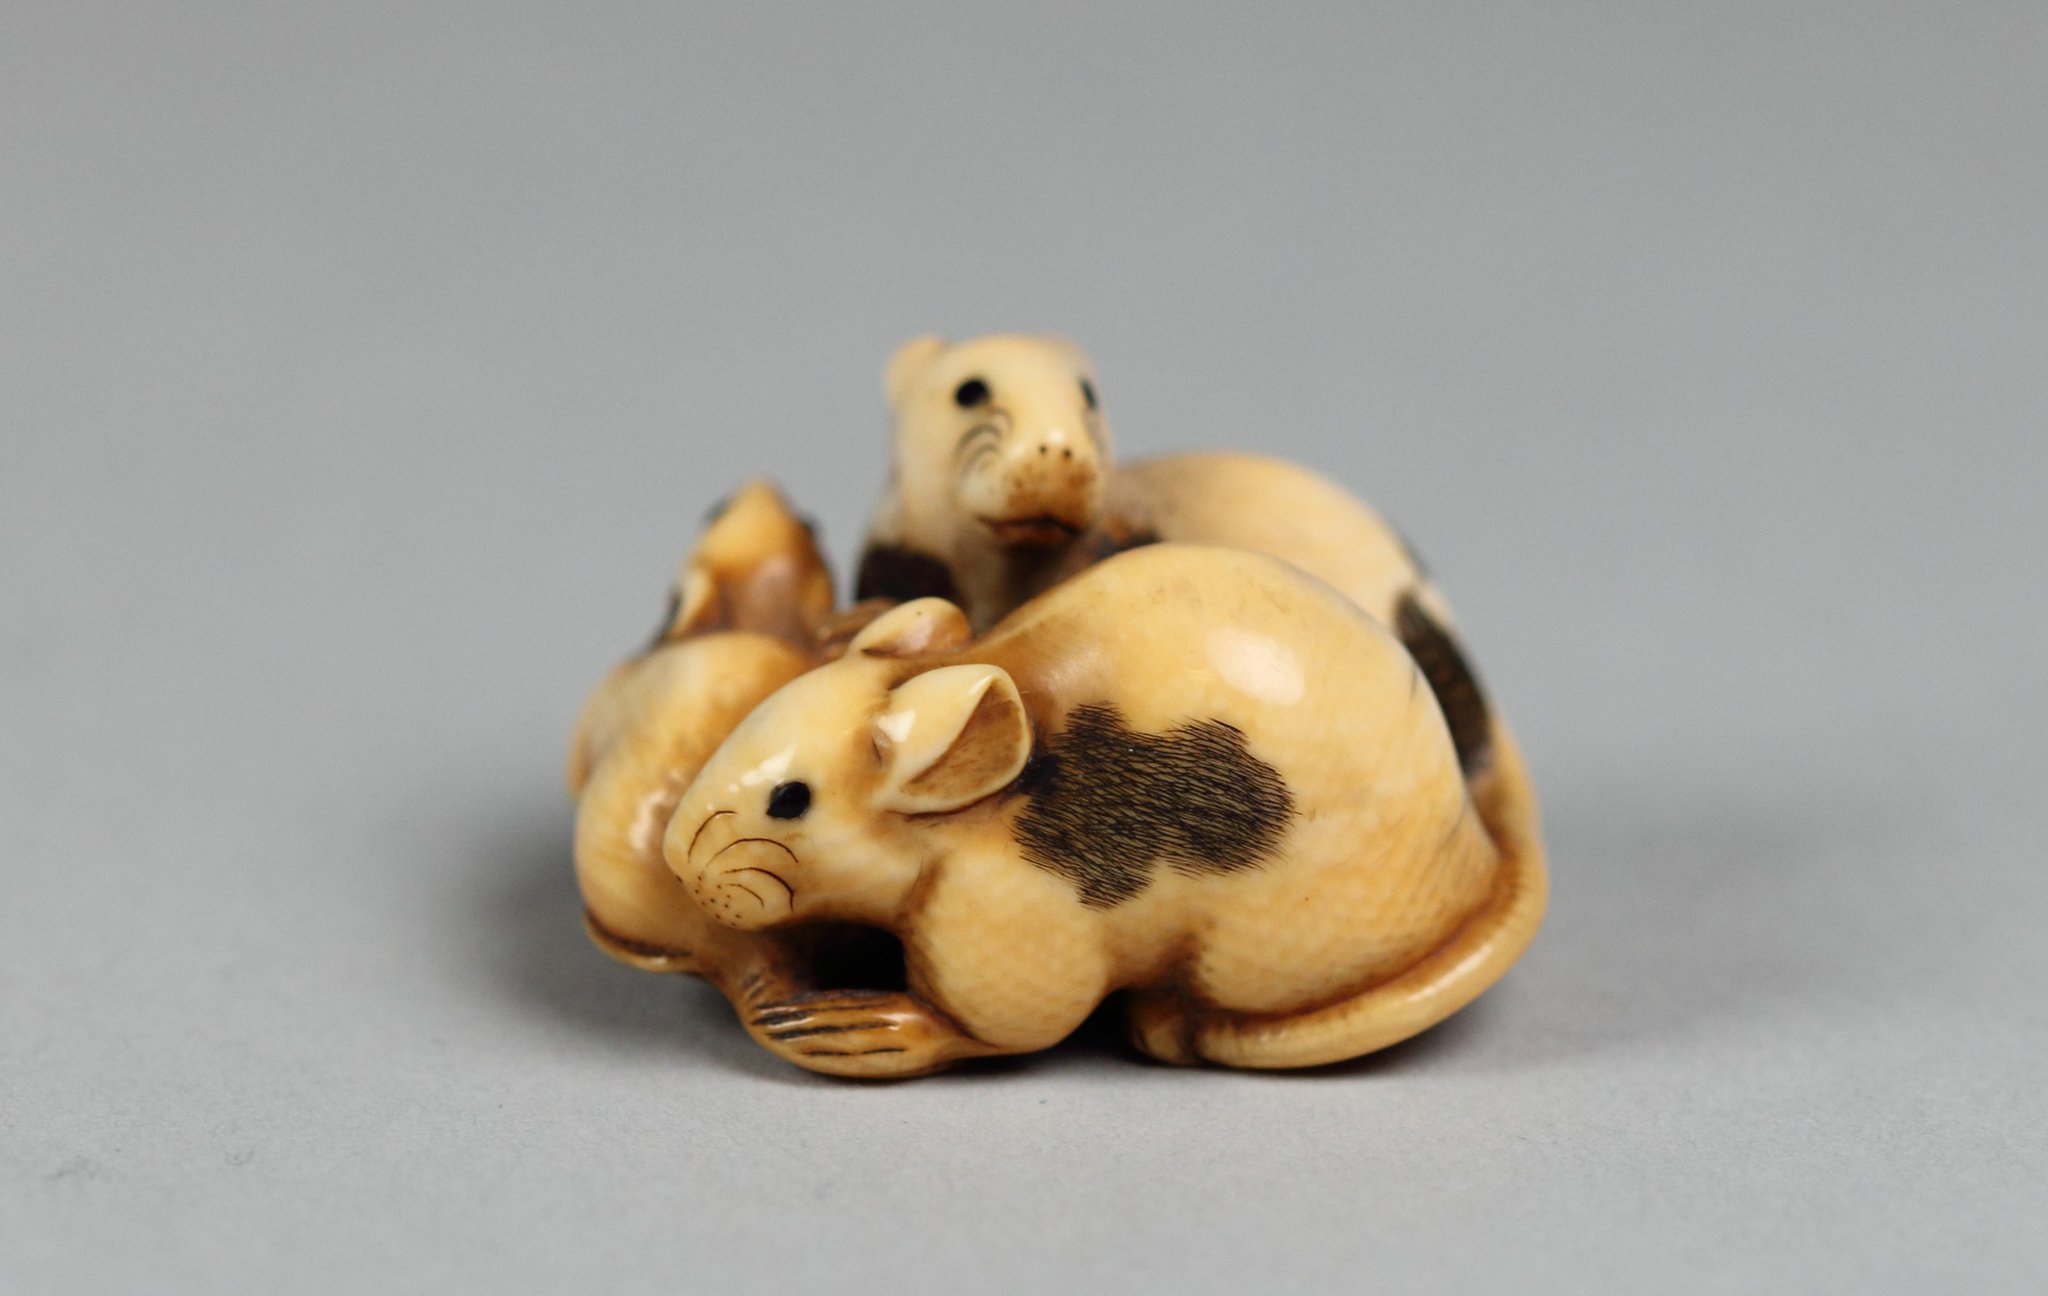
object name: netsuke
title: Netsuke of Three Rats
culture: japanese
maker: nagahisa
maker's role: artist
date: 1801-1850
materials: ivory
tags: rats